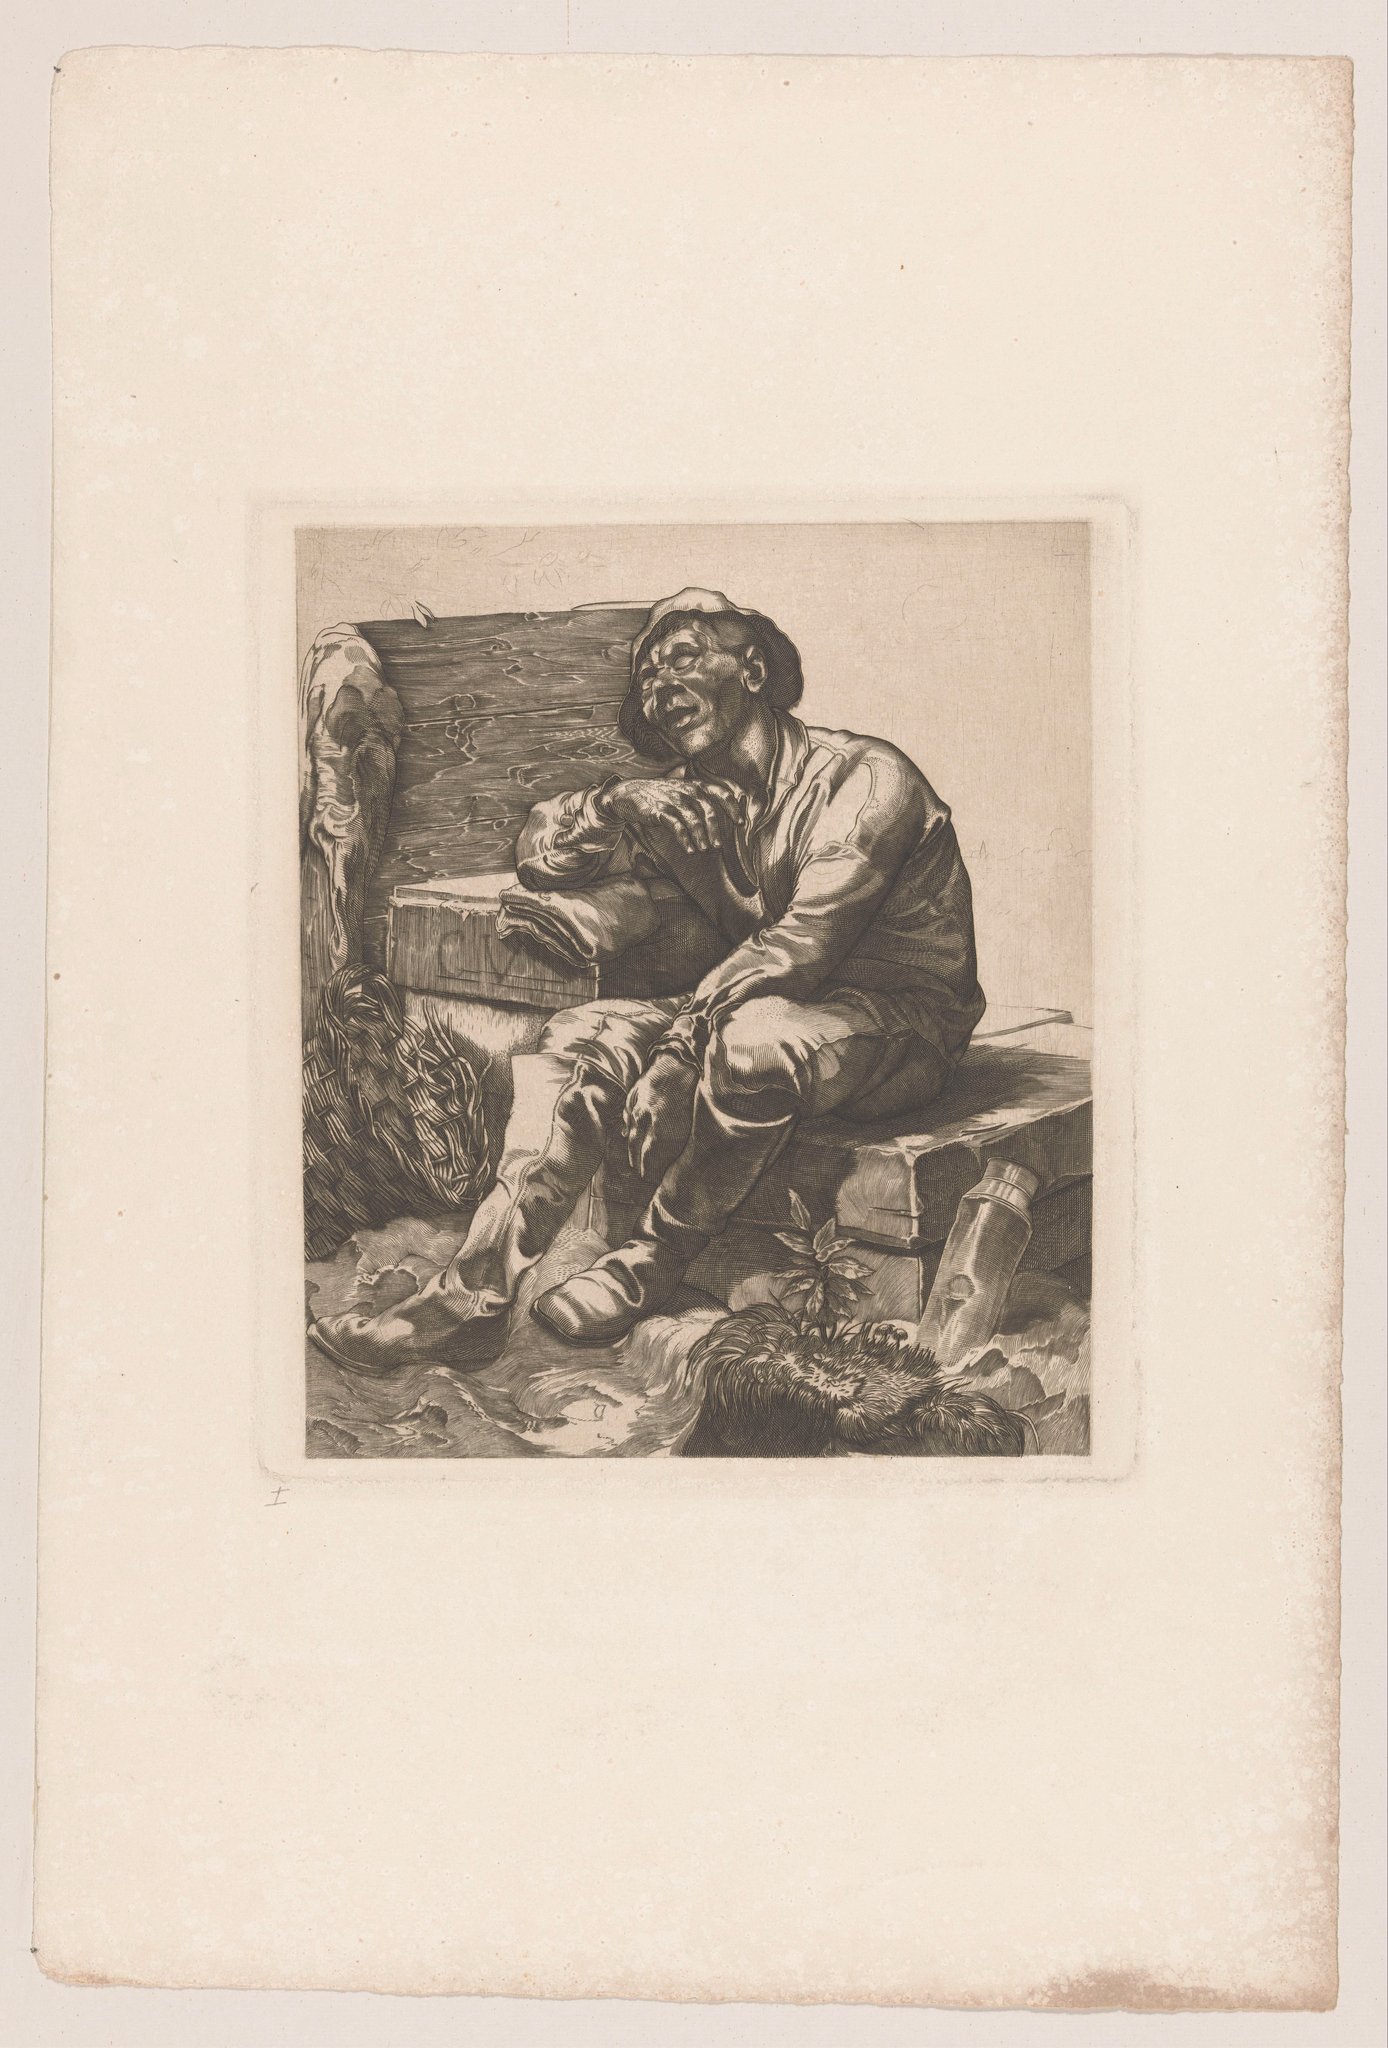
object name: print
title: Rustende polderjongen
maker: johannes josephus aarts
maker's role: draughtsman, print maker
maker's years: 1871-1934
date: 1881-1934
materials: paper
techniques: engraving, intaglio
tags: sleeping; unconsciousness - bb - out of doors, working class, labourers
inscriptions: collector's mark: Lugt 2166, collector's mark: Lugt 2760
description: Een man in werkkleding en met hoed, zittend en slapend op een houten bank. Linksboven een tak met bladeren, rechtsonder een drinkfles. Rechts op de achtergrond een nederzetting met kerktoren.